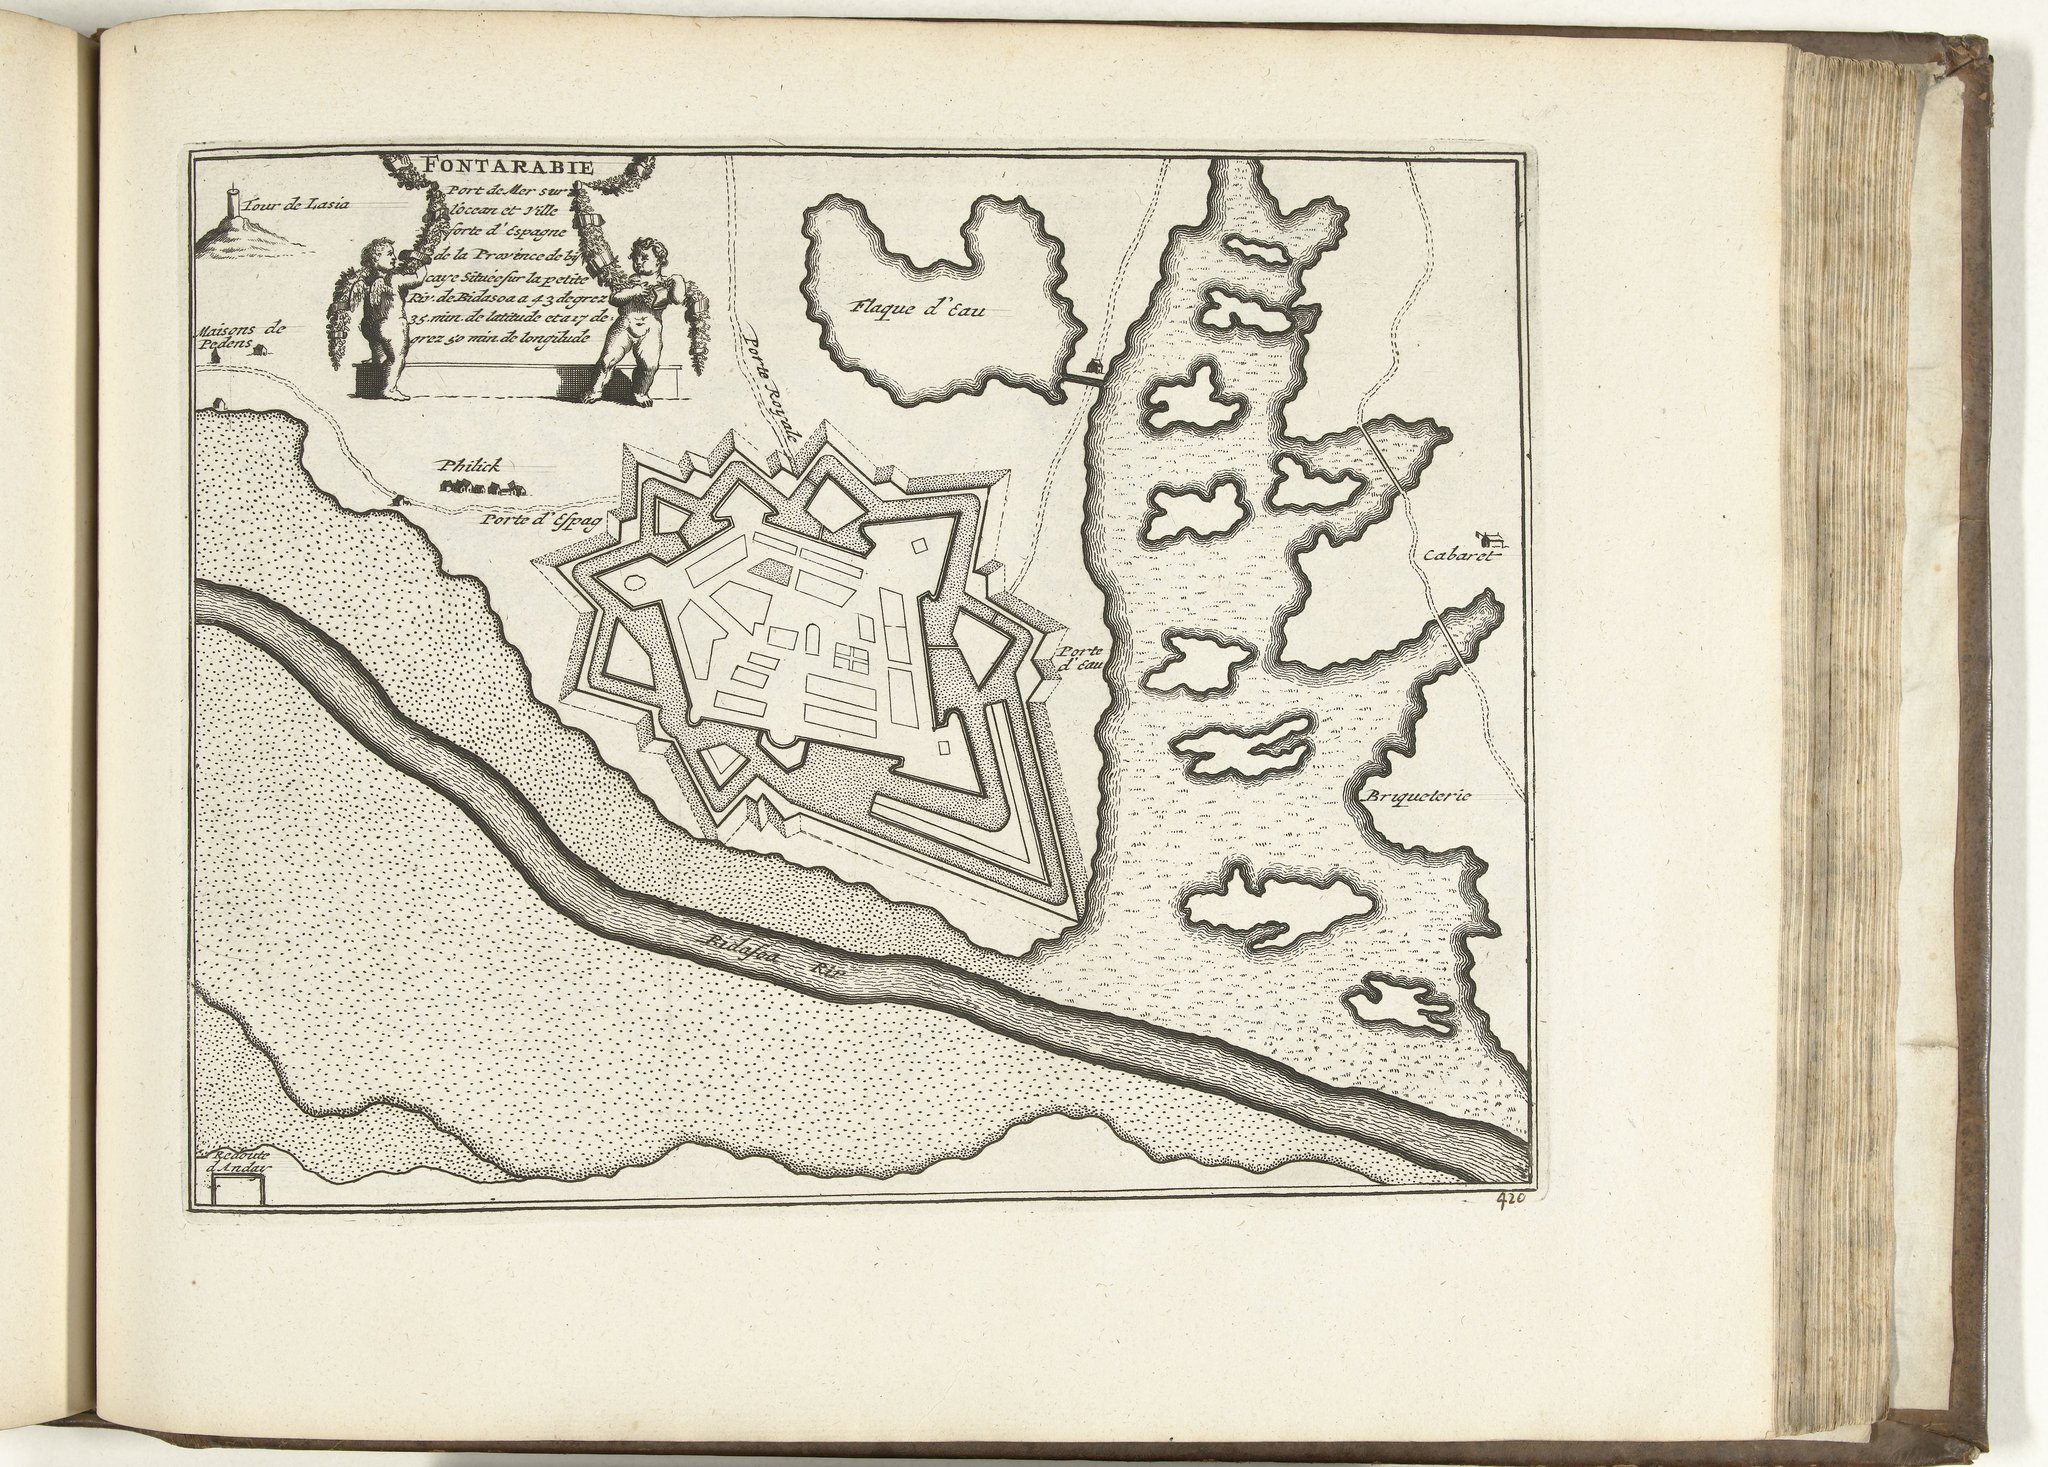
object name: map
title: Fontarabie Port de Mer (...)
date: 1726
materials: paper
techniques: etching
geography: leiden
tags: fortress, maps of separate countries or regions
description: Plattegrond van de versterkingen om de Franse stad Fuenterrabía. Plaat nr. 420 in deel XVII van het prentwerk: Les Forces de l'Europe, Asie, Afrique et Amerique ... Comme aussi les Cartes des Côtes de France et d'Espagne uit 1726, dit tweede deel met 271 met de hand genummerde platen van vermaarde sterke steden en vestingen in het kader van de Spaanse Successieoorlog 1701-1713. Voor het merendeel zijn deze platen gekopieerd naar de anonieme Franse platen van vermaarde sterke steden en vestingen: in Les forces de l'Europe en in: Le theatre de la guerre, dans les Pays-Bas, beide oorspronkelijk uitgegeven door Nicolas de Fer te Parijs (1693-1697) in het kader van de Negenjarige Oorlog. Titel en opschriften in het Frans.